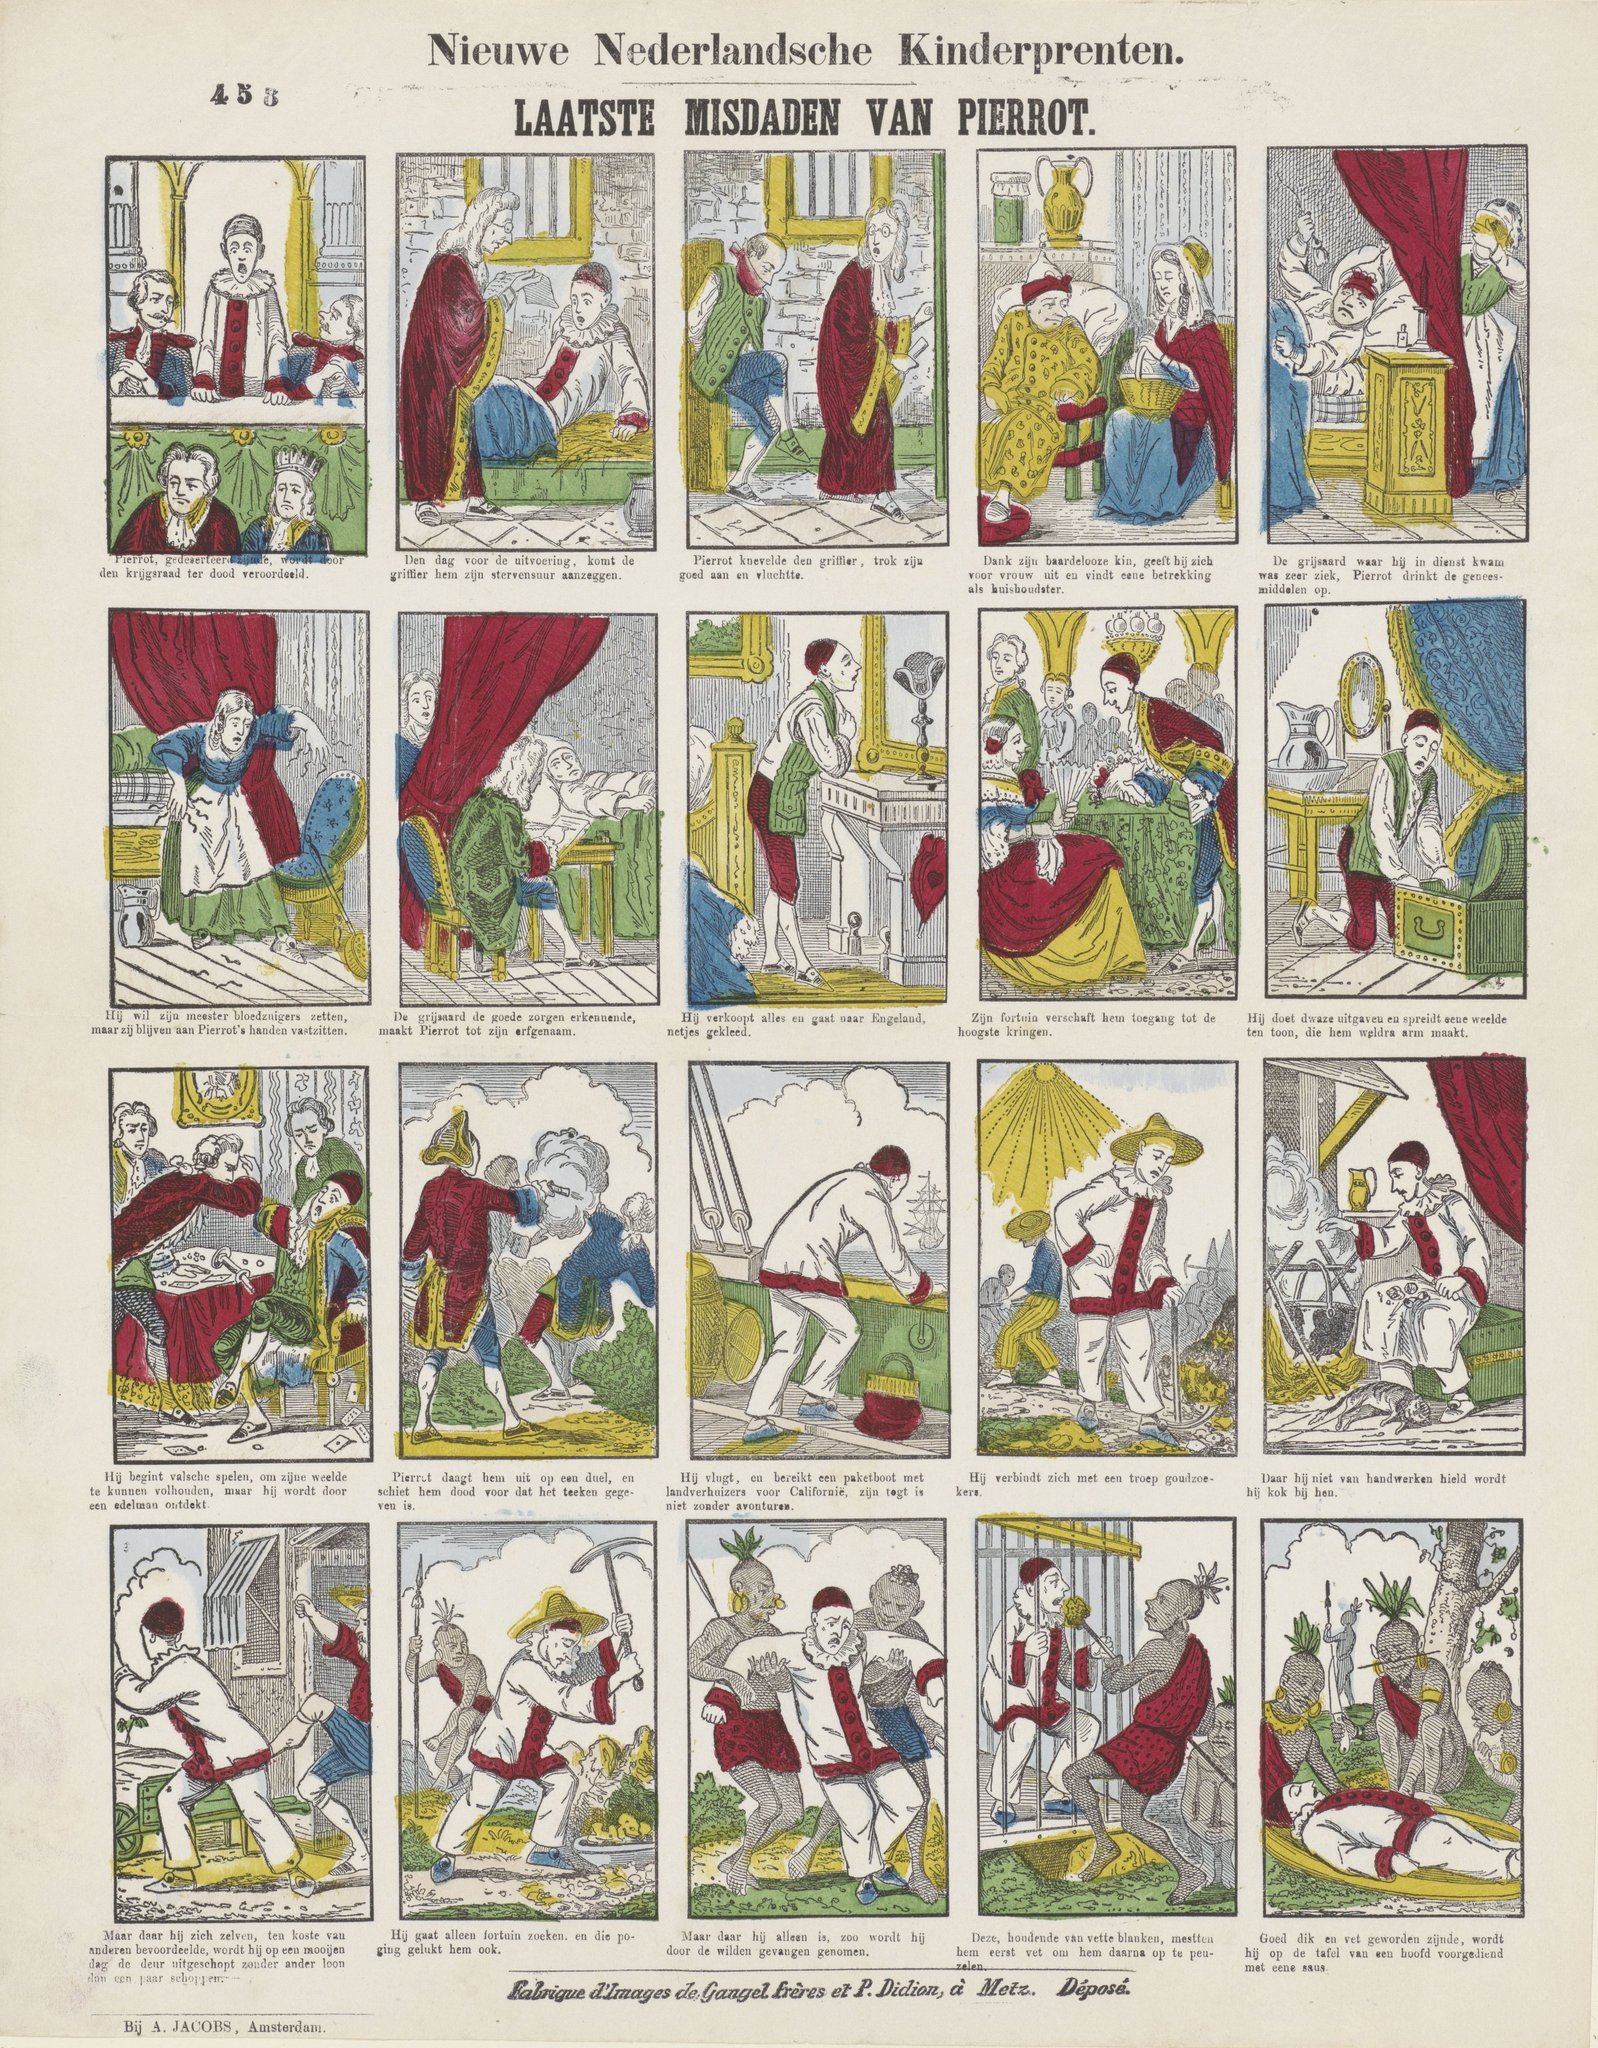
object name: print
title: Nieuwe Nederlandsche kinderprenten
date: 1851-1860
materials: paper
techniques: hand coloring, letterpress printing, lithograph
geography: metz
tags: types in 'commedia dell'arte': pierrot, tales and fairy tales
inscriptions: collector's mark: Lugt 2760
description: Blad met 20 voorstellingen uit het verhaal van Pierrot. Onder elke afbeelding een onderschrift. Genummerd linksboven: 453.